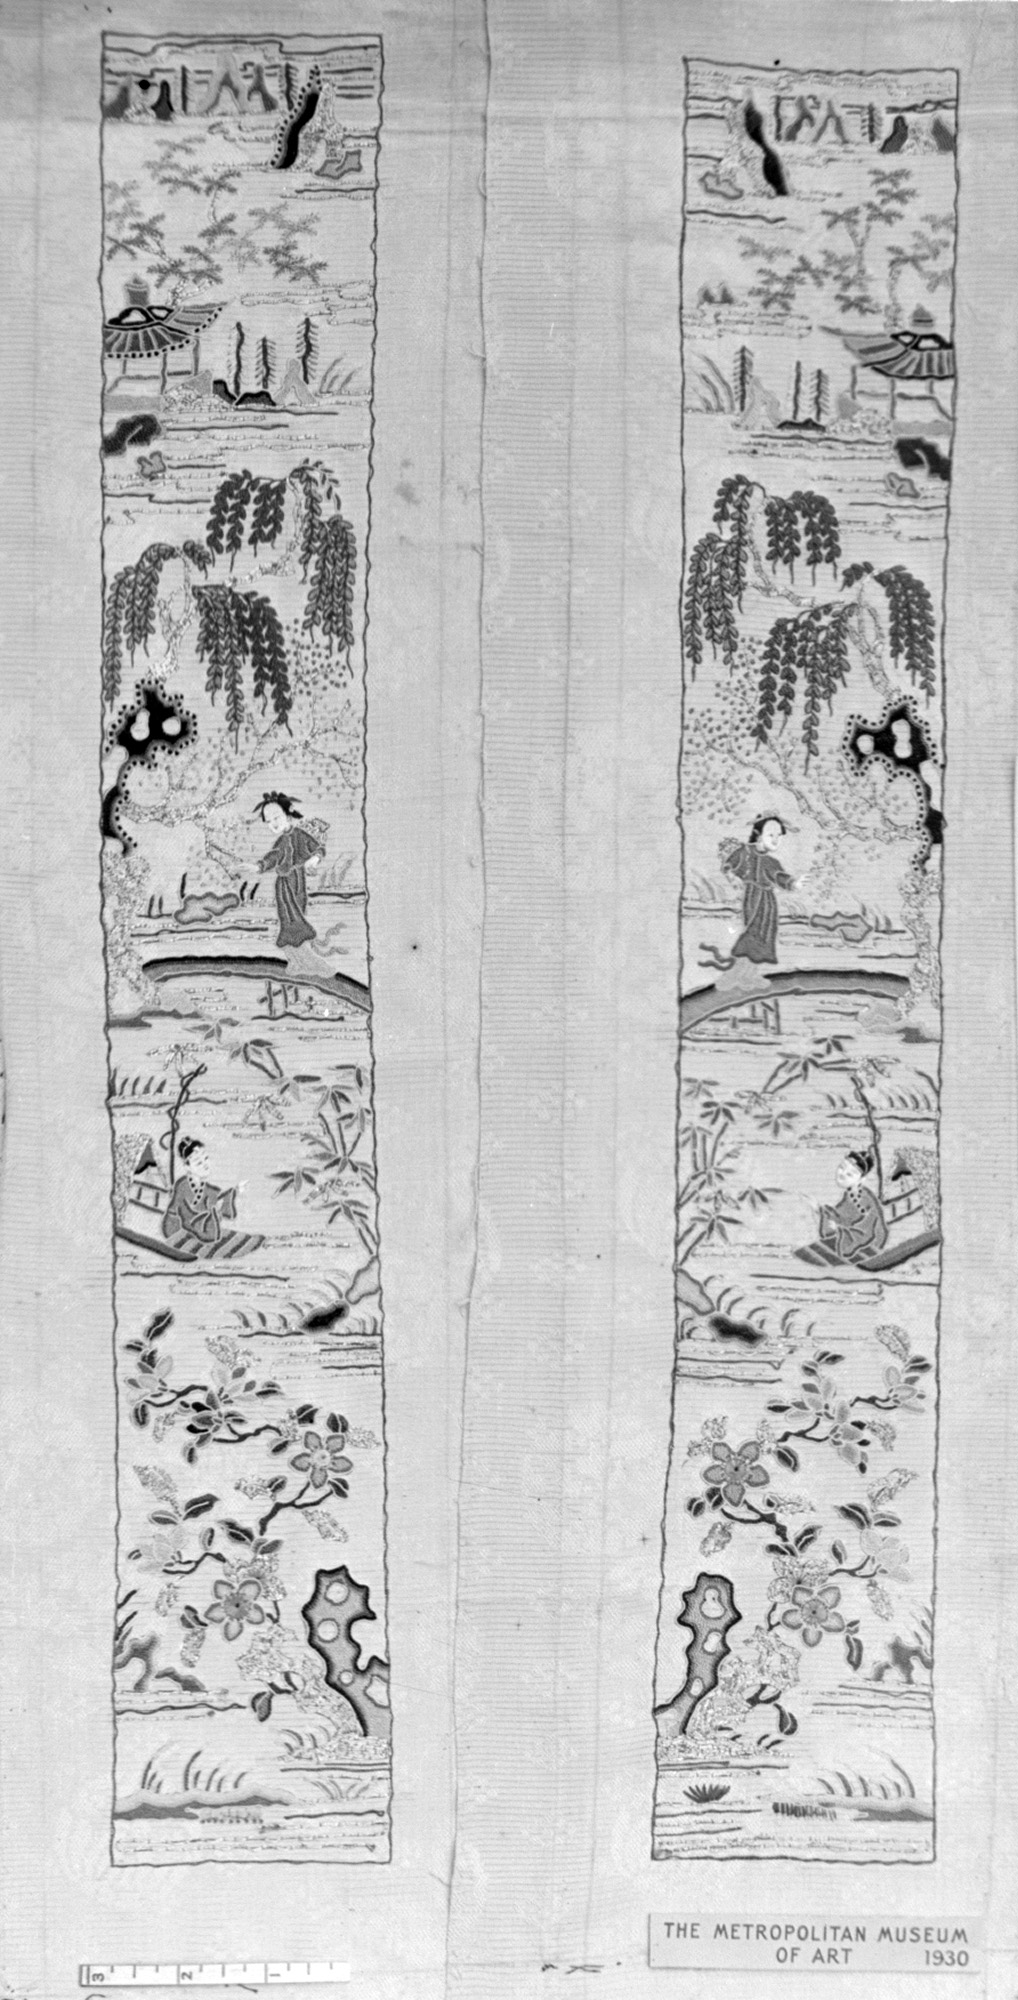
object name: sleeve band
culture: chinese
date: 1801-1900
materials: metal thread, silk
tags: flowers